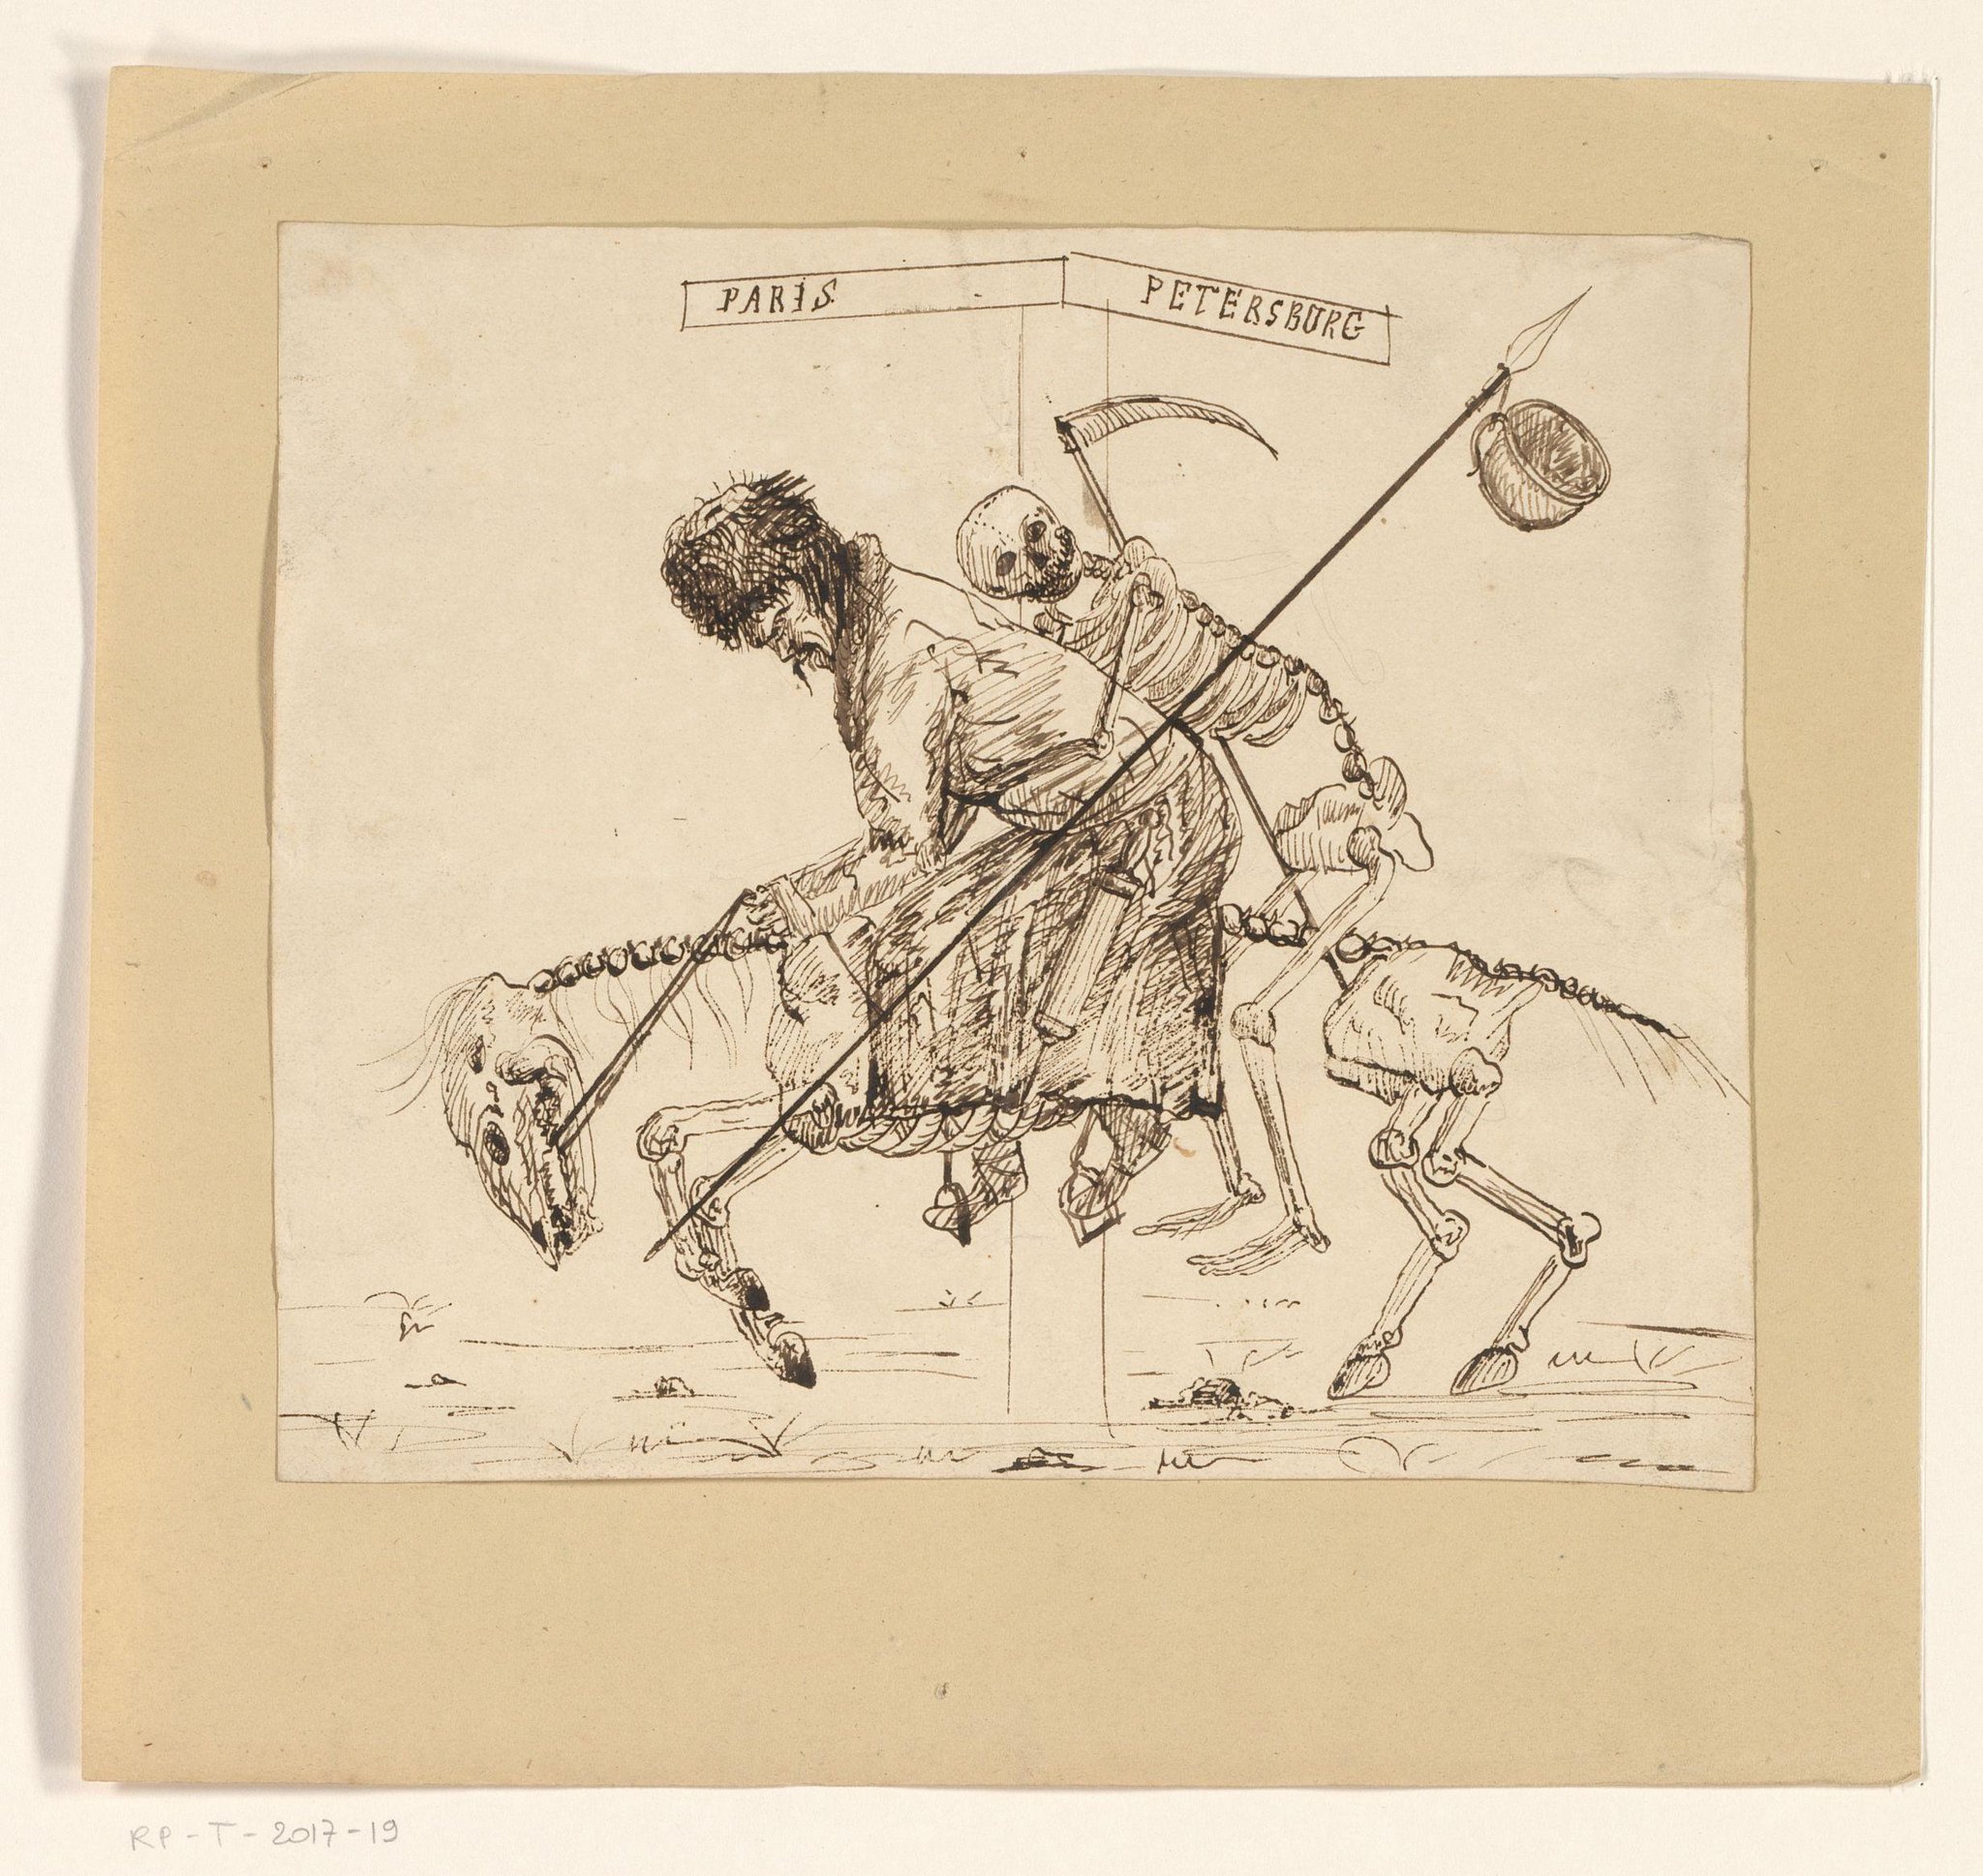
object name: drawing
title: Franse terugtocht uit Rusland, 1812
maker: Anonymous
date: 1812-1815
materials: ink, paper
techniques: pen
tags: retreat of the defeated, political caricatures and satires, death as skeleton (+ death riding on a horse), russia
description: Spotprent, waarschijnlijk op de Franse terugtocht uit Rusland, 1812. Een ruiter voorover gebogen rijdend op het skelet van een paard, de Dood zit achter hem en omarmt hem. Achter hen wegwijzers naar Parijs en Sint-Petersburg.